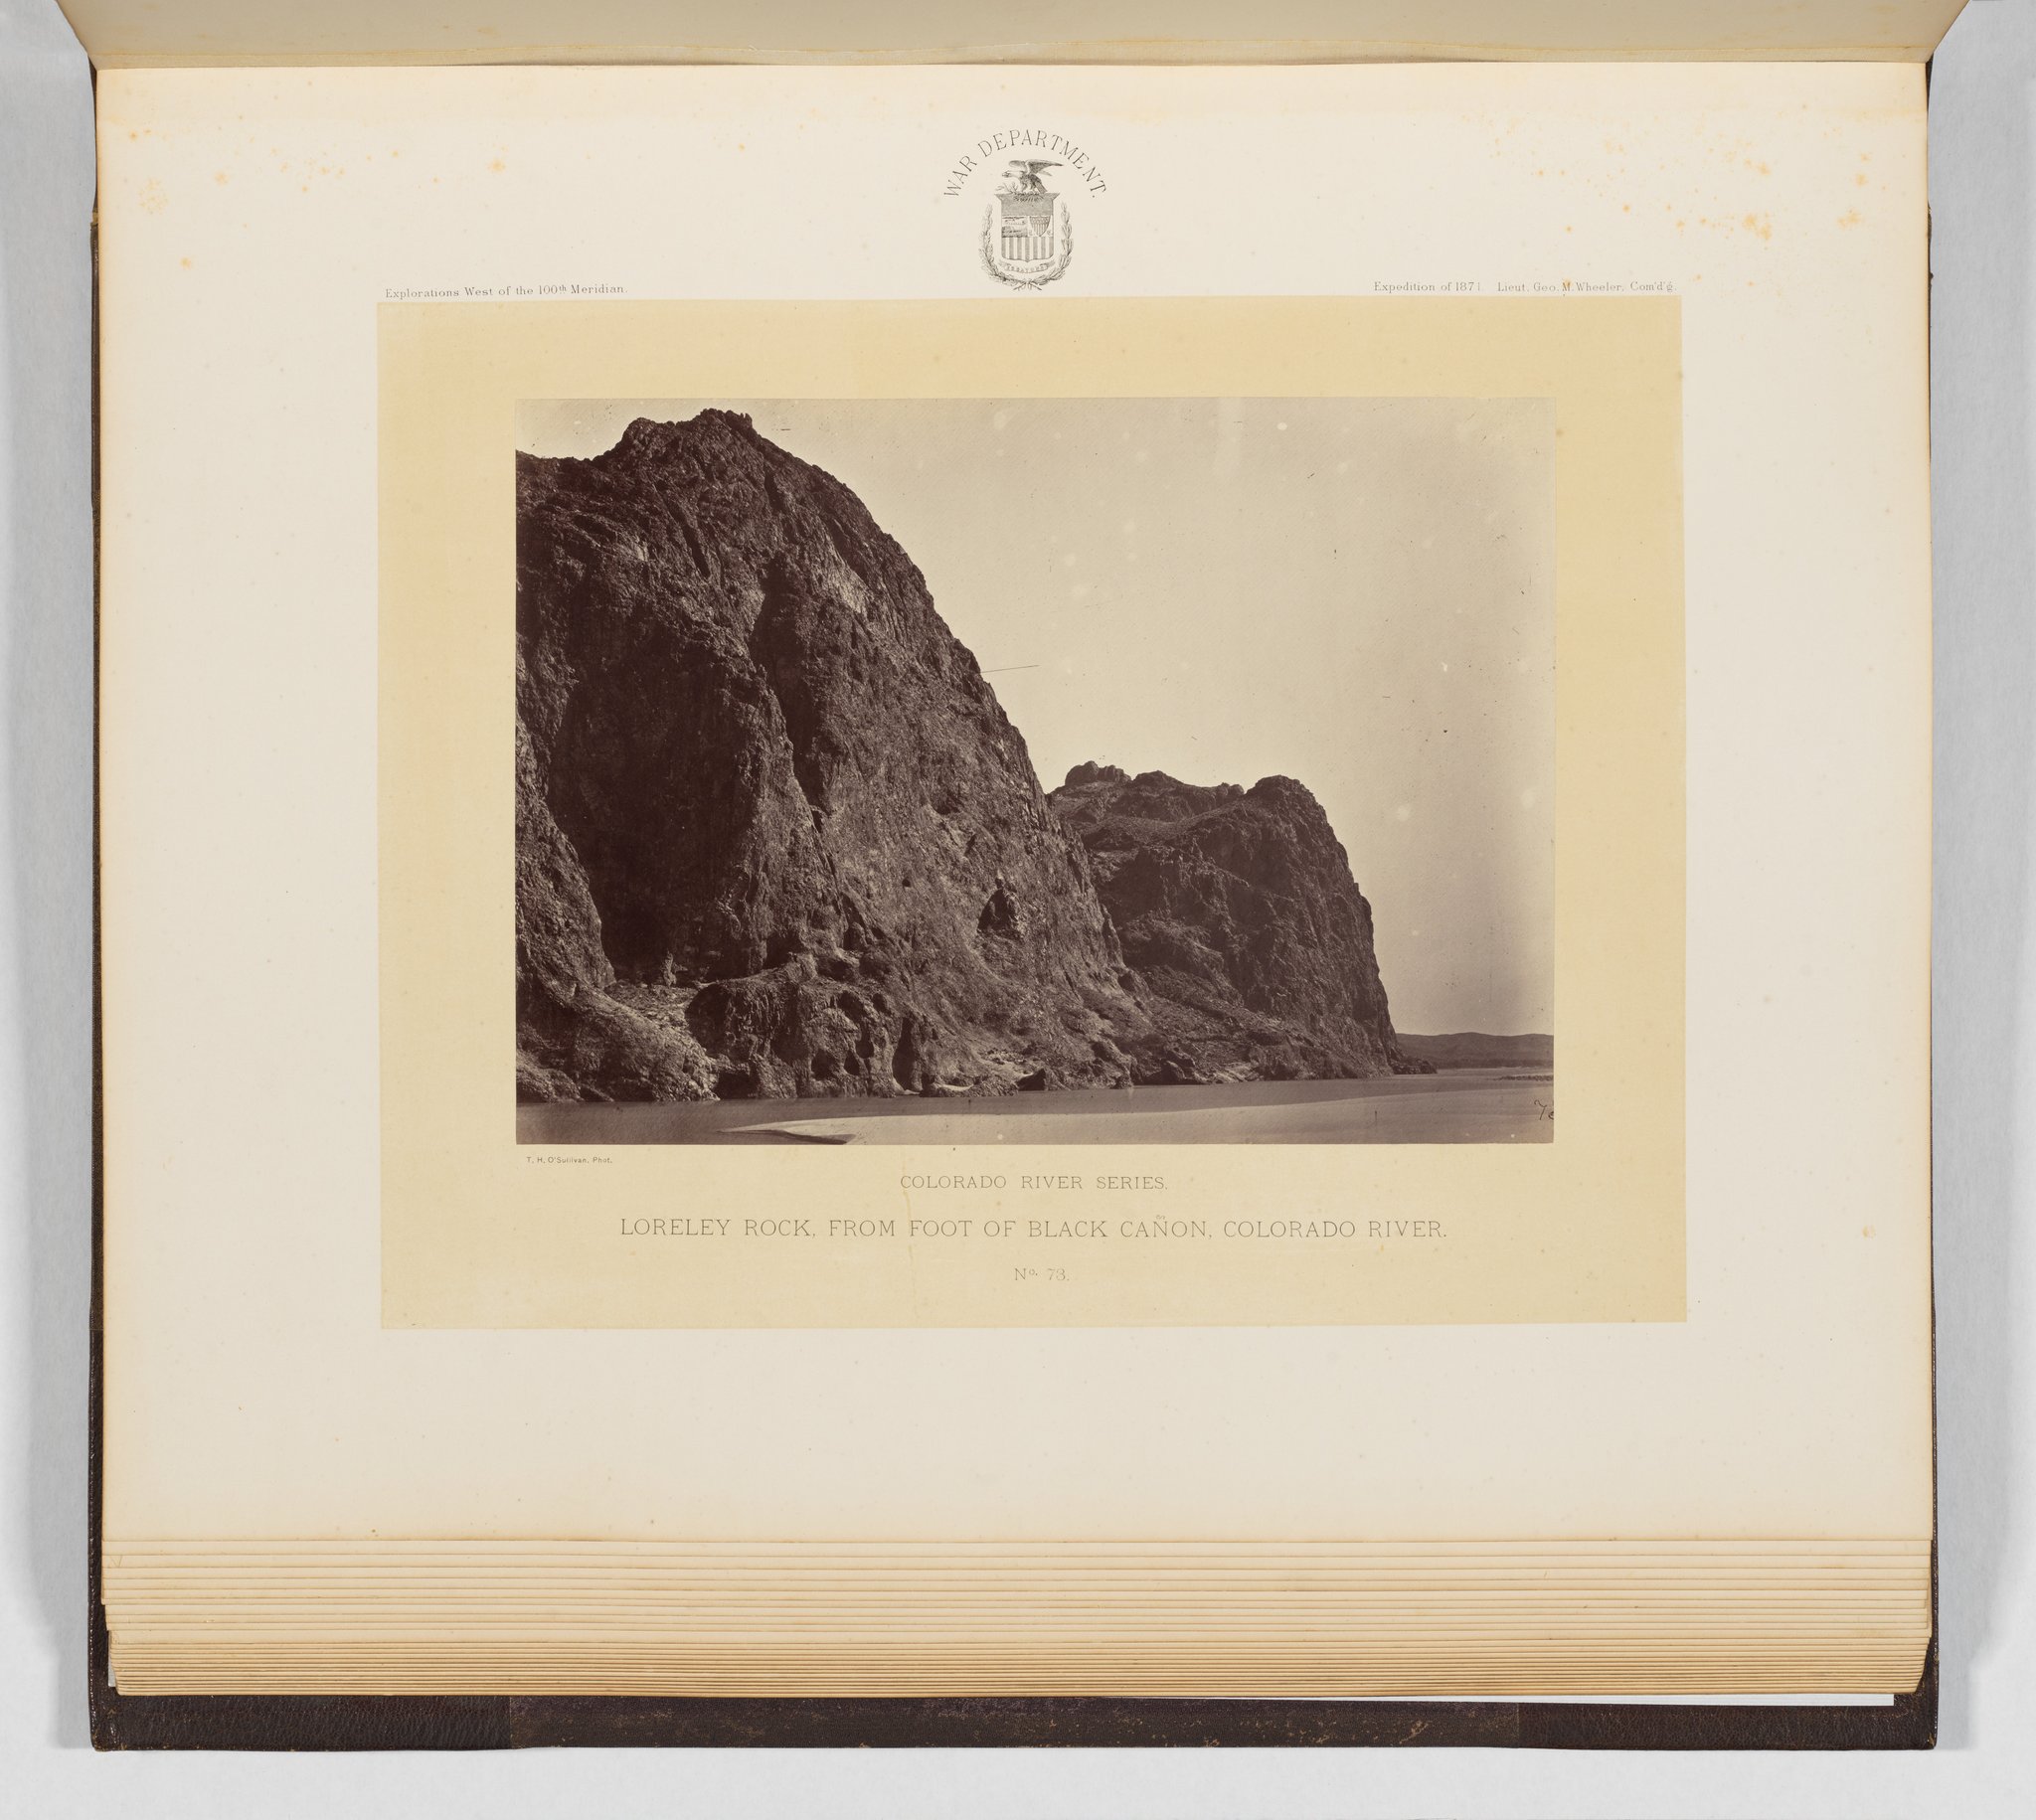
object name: photograph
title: Loreley Rock, From Foot of Black Cañon, Colorado River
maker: timothy h. o'sullivan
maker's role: artist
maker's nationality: american, born ireland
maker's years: 1840-1882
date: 1871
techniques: albumen silver print, glass negative